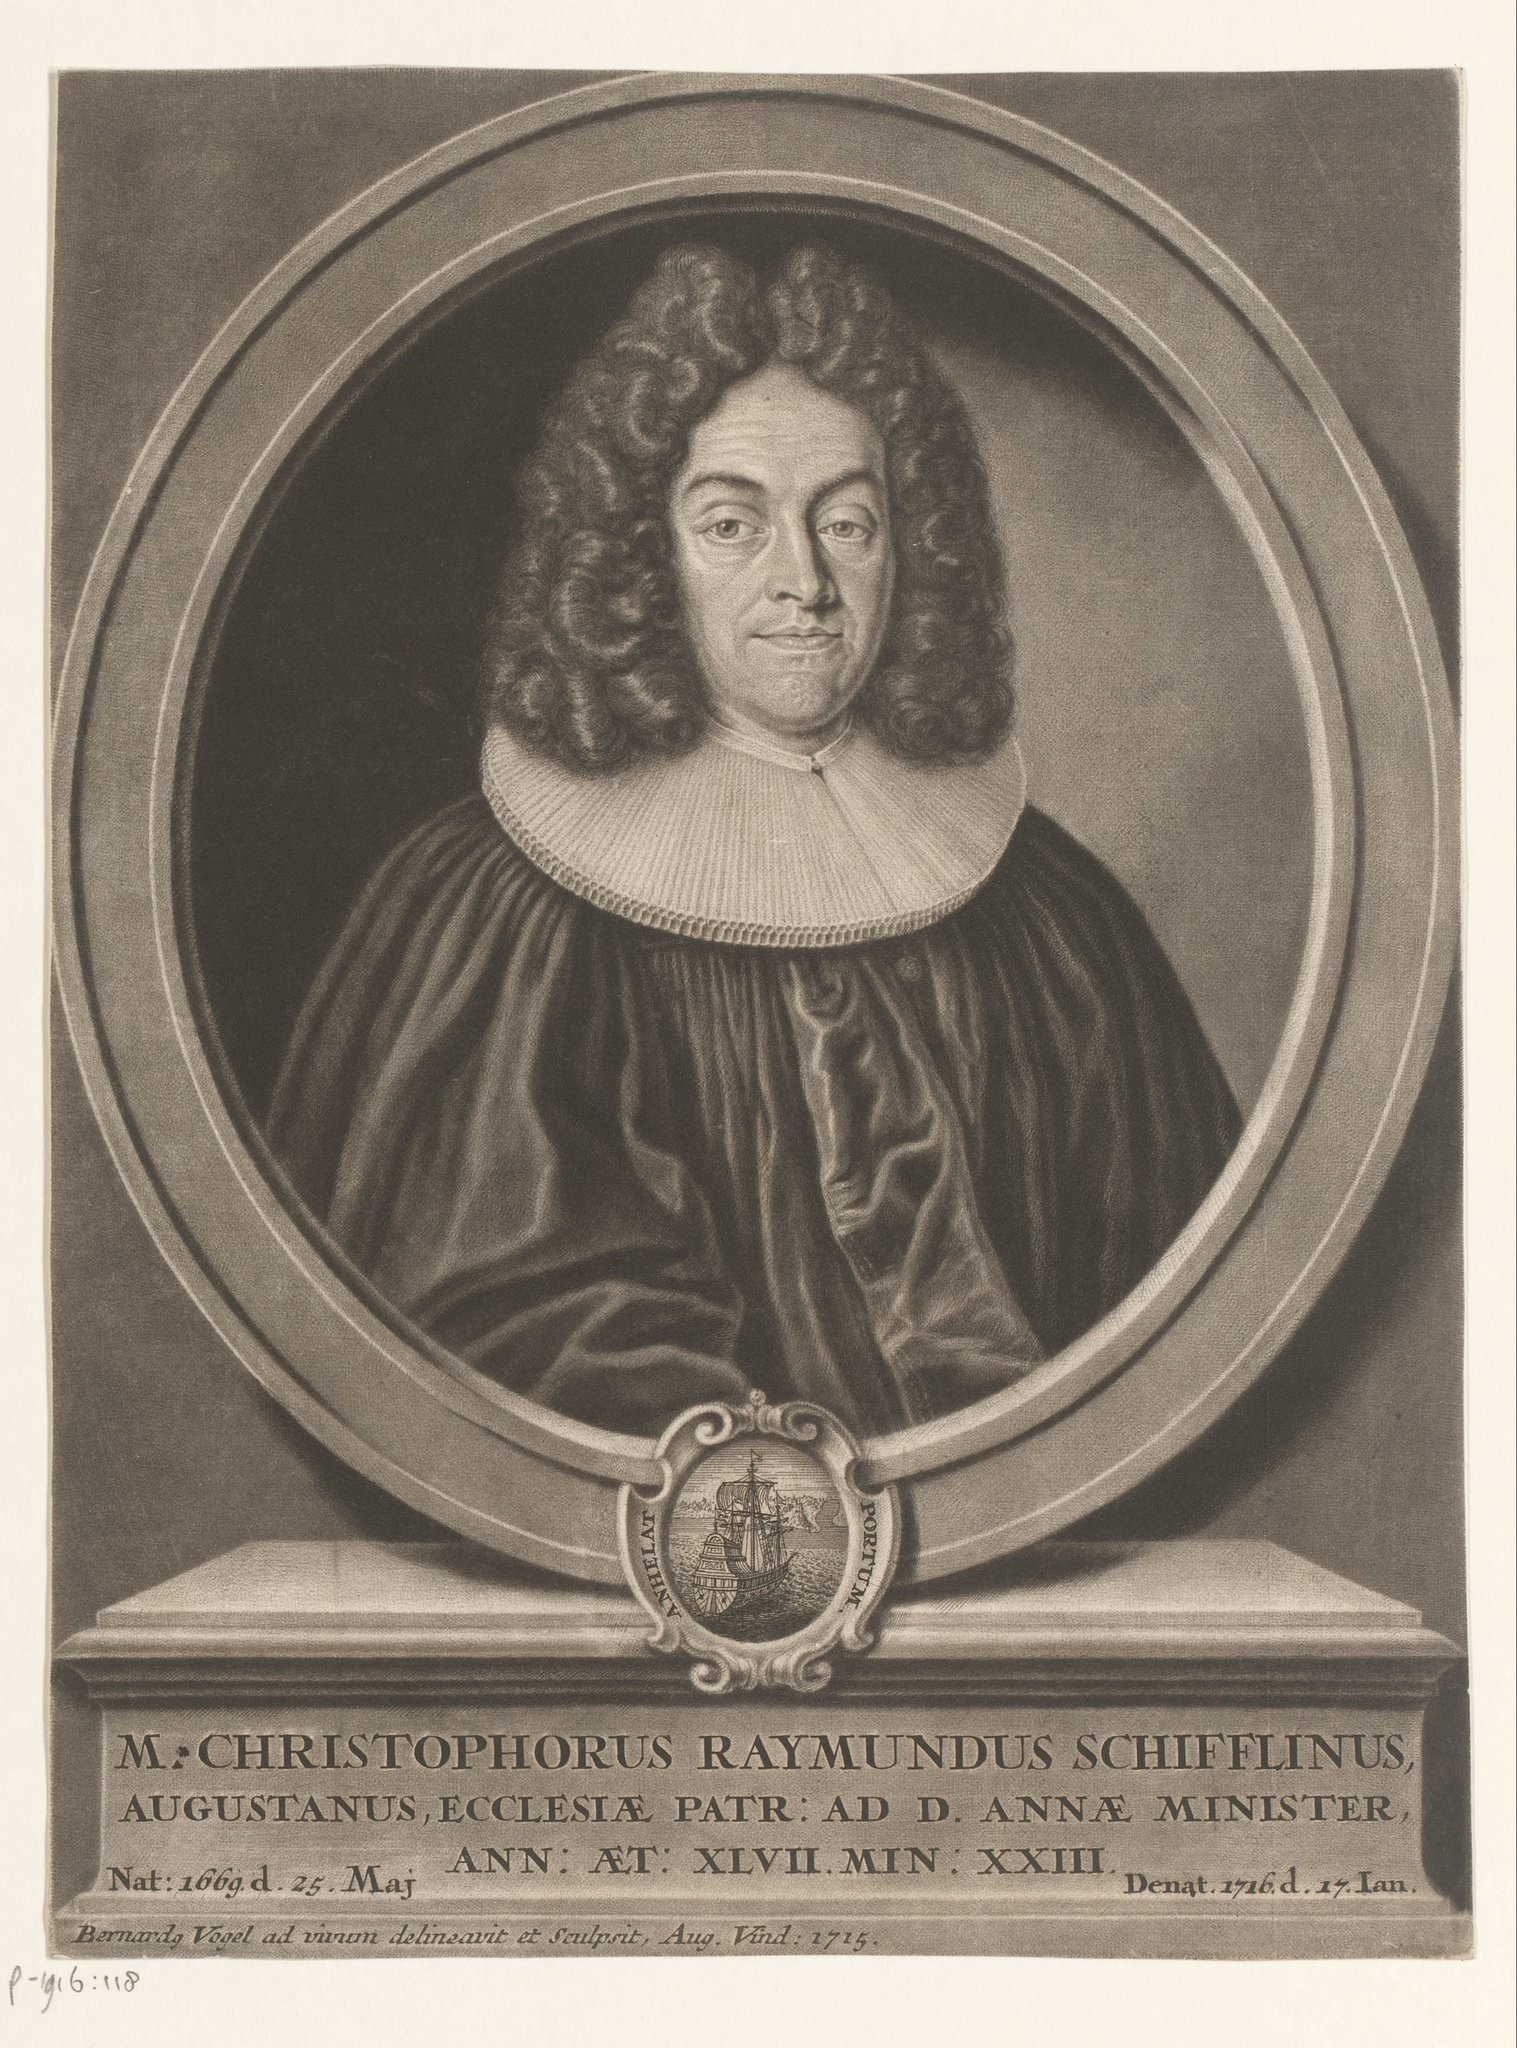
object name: print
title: Portret van Christoph Raimund Schifflin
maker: bernhard vogel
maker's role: draughtsman, painter, print maker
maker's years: 1683-1737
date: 1715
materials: paper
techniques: mezzotint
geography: augsburg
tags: historical persons, armorial bearing, heraldry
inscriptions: collector's mark: Lugt 2228